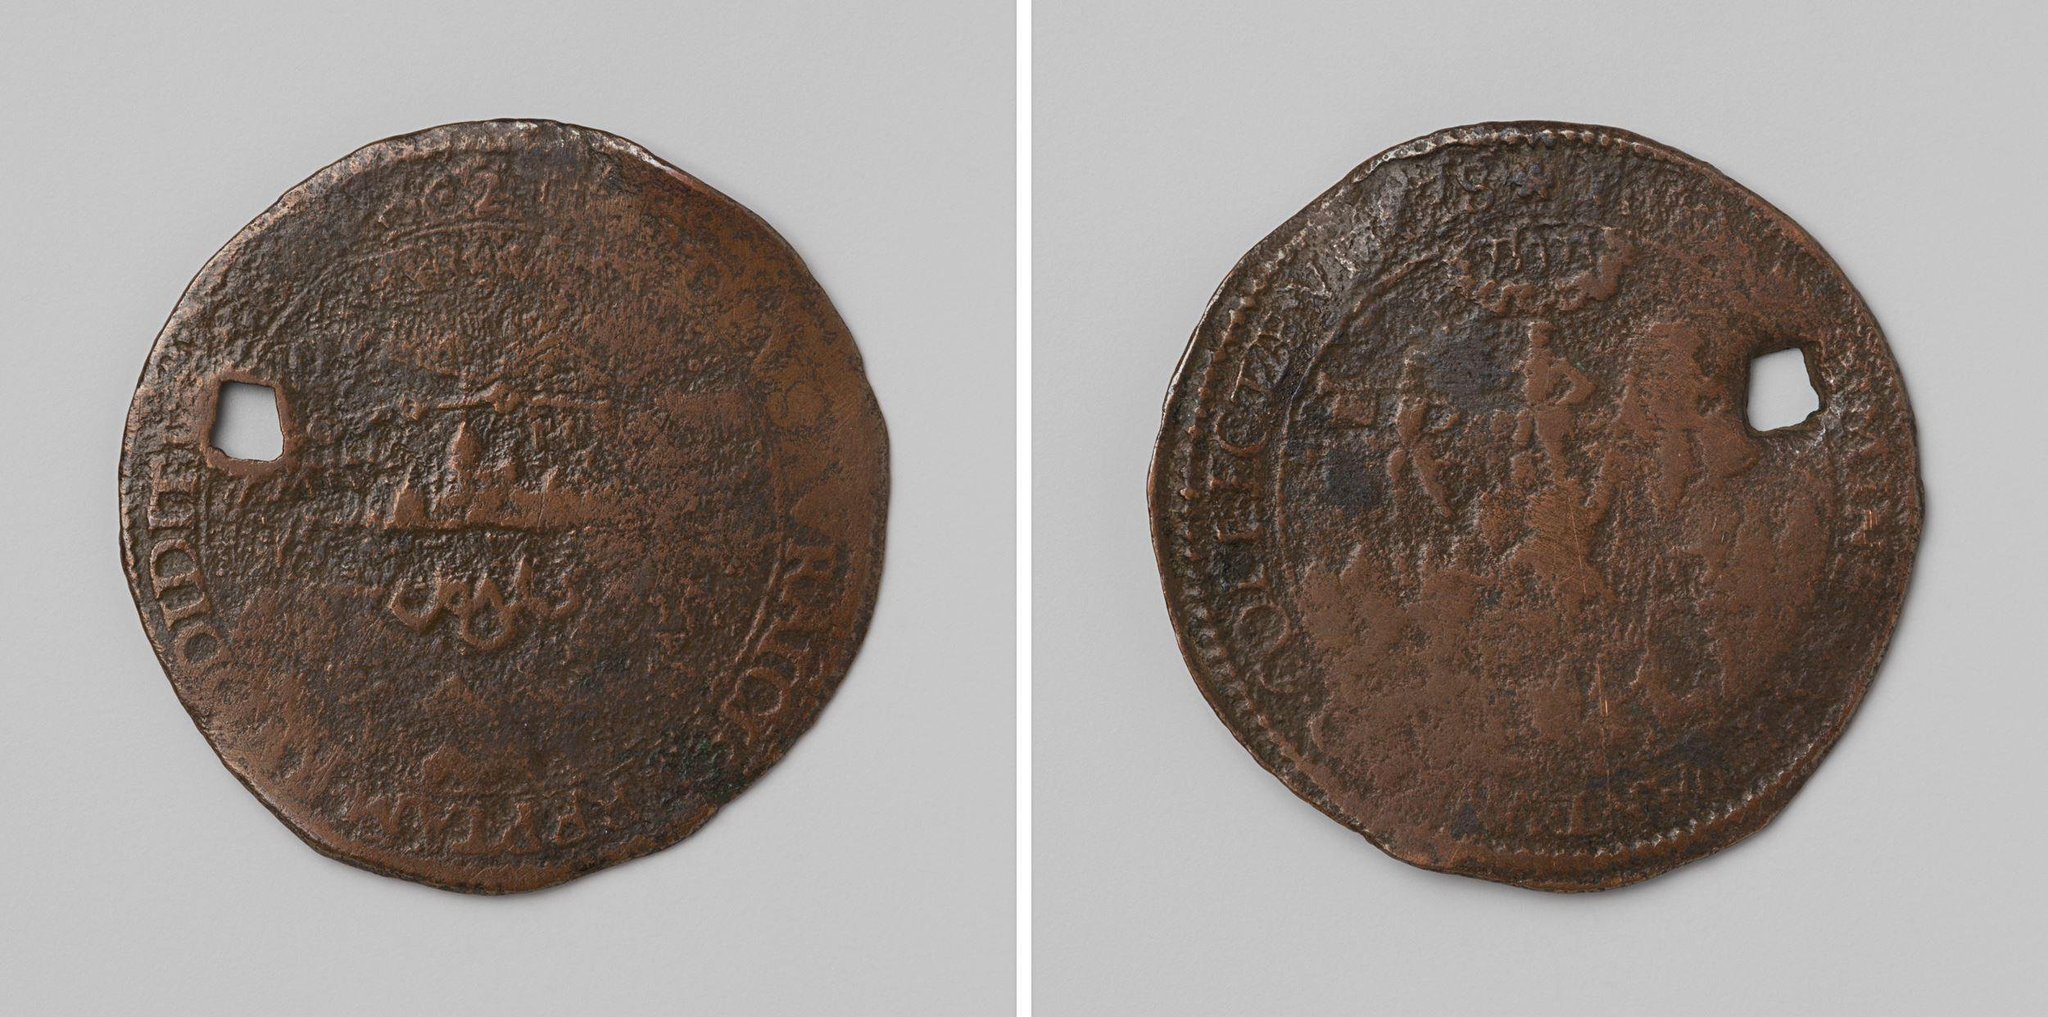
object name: jeton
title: Mislukte onzet van Rheinberg door de graaf van Berg en inname van Grave door Maurits, graaf van Nassau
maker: Anonymous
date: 1602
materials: copper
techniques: striking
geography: dordrecht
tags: the hague, maurice (prince of orange), grave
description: Koperen penning met gat erin. Voorzijde: gezicht op stad Grave en belegeraars onder opschrift binnen omschrift. Keerzijde: ontzettingsleger van de graaf van Berg, voorafgegaan door tamboer en trompetter, beschenen door hemellicht, waarin naam Jehova in Hebreeuws staat geschreven binnen omschrift